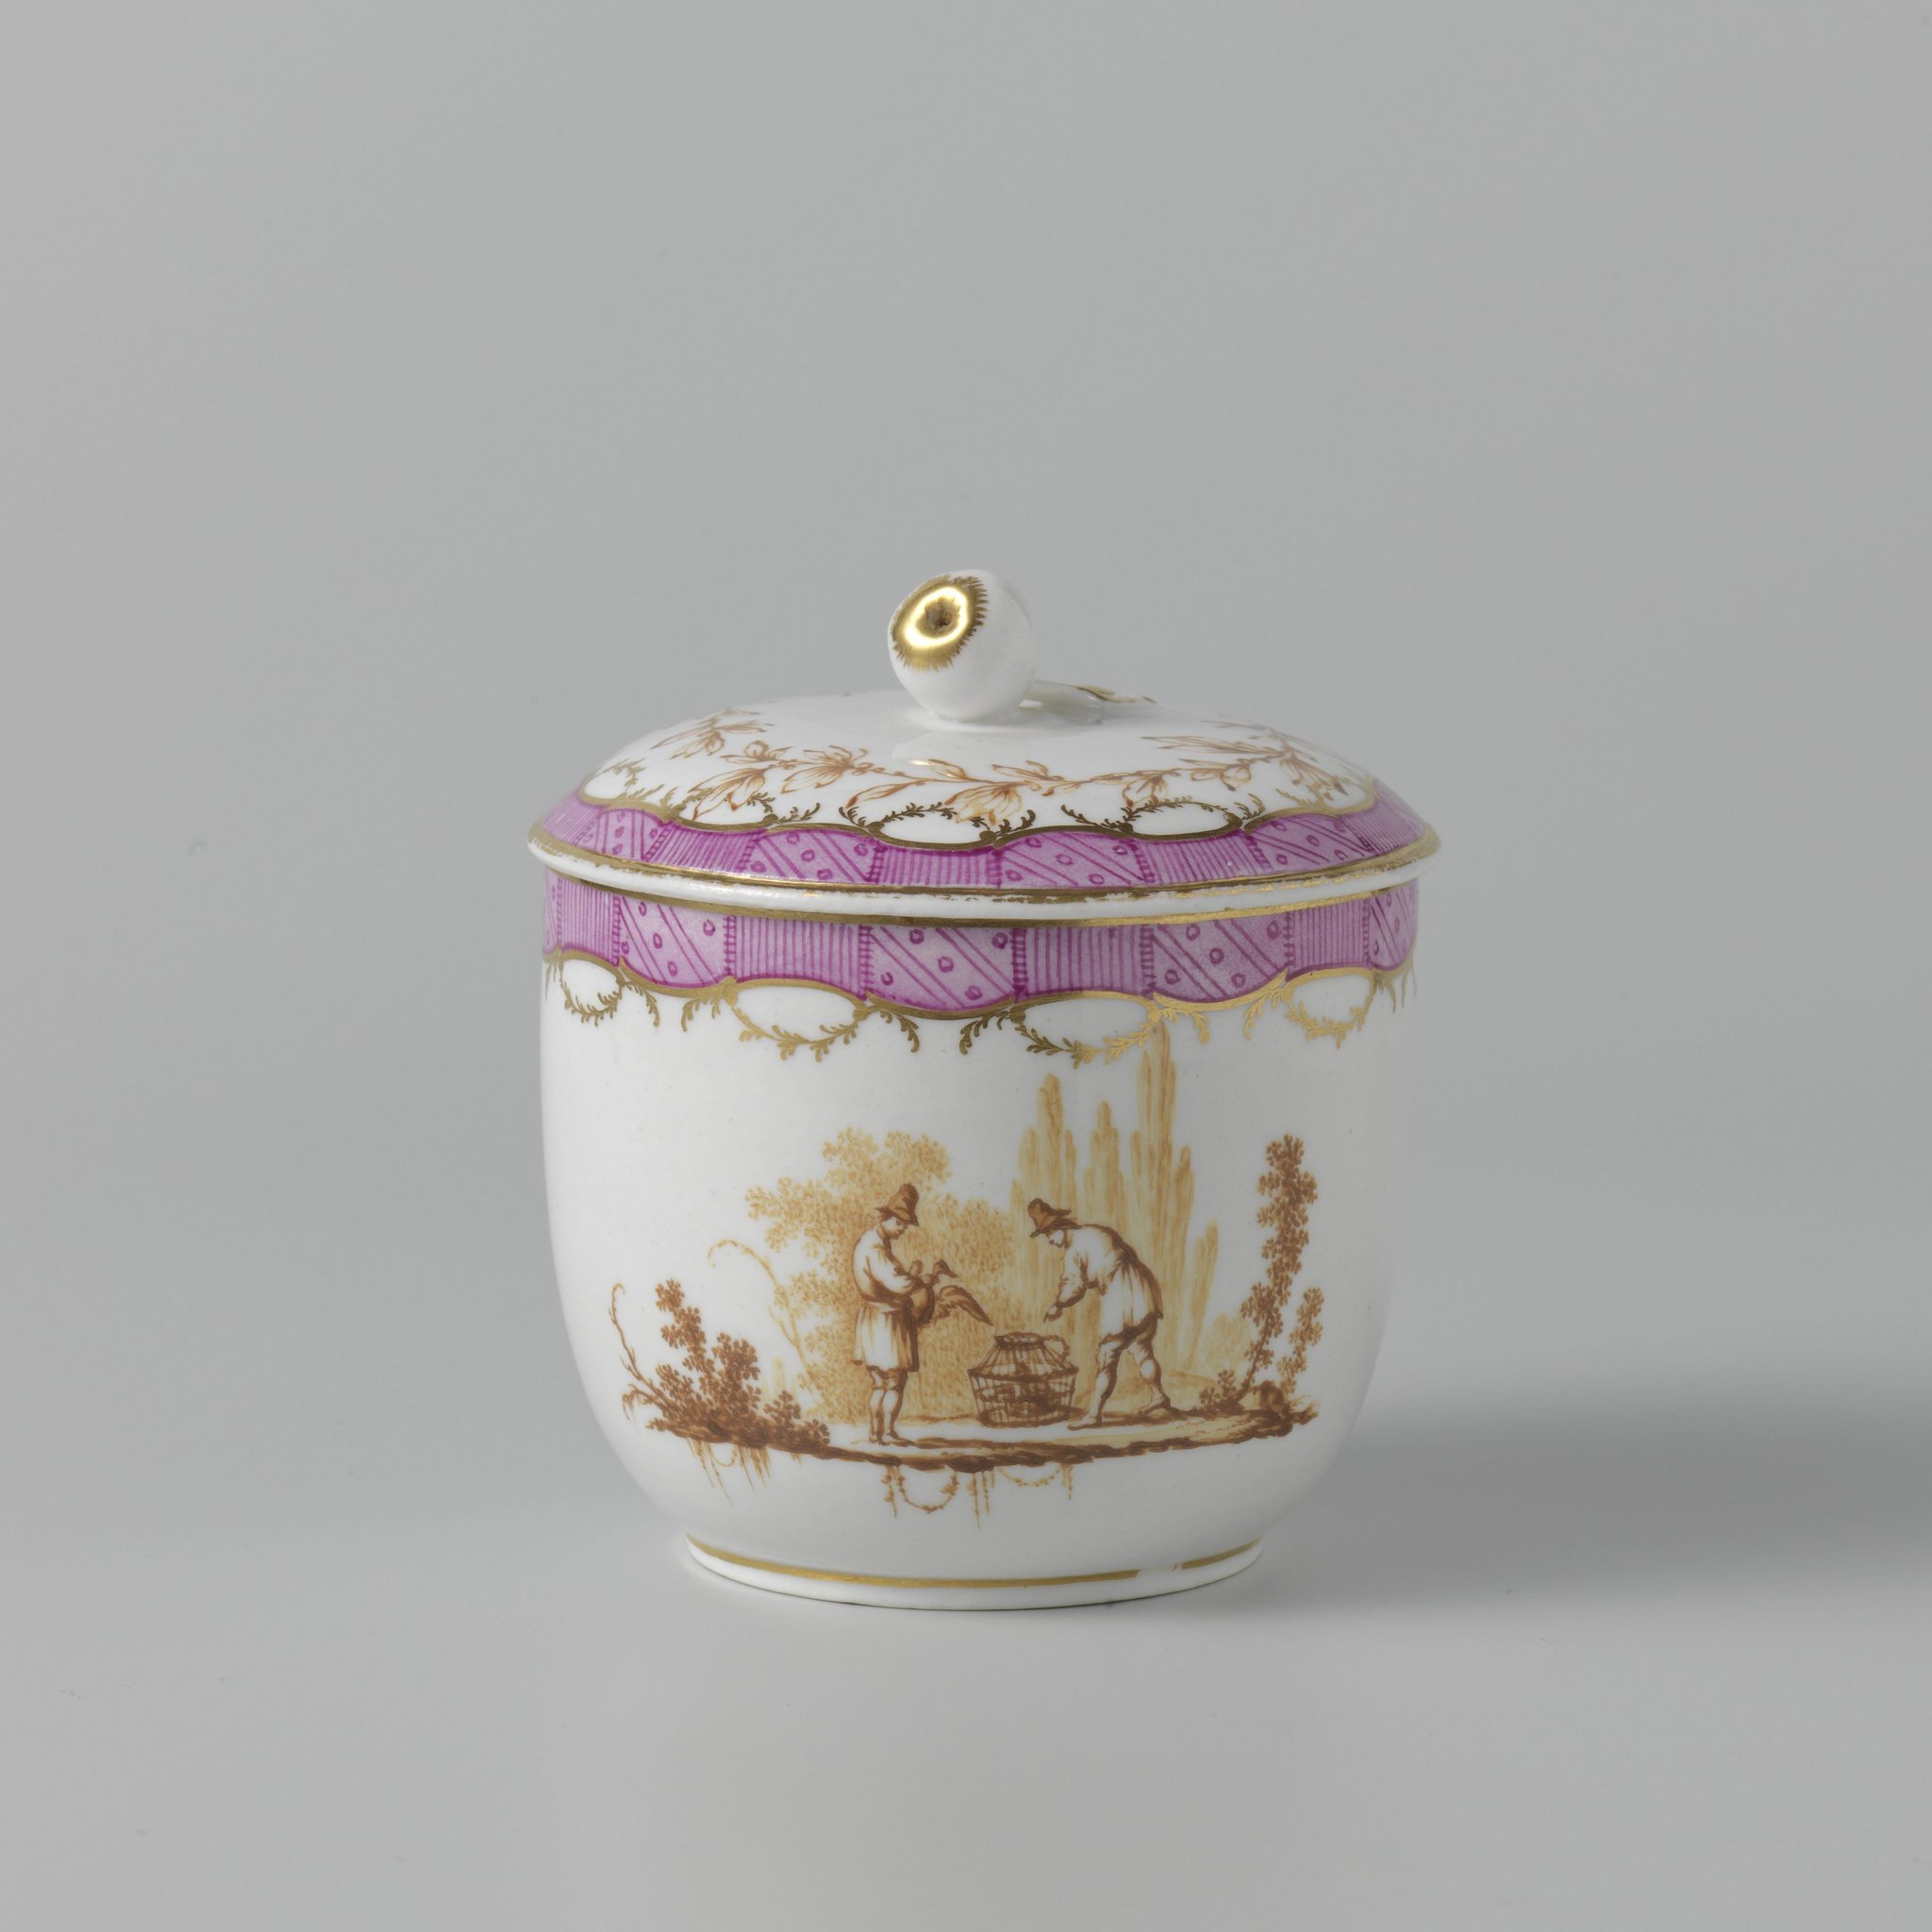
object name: sugar box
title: Tea service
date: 1774-1778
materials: porcelain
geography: loosdrecht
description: Tea services represented a significant part of the production of the Loosdrecht porcelain factory. On display here are a teapot, milk jug and sugar bowl along with other less familiar parts of a tea service, such as a slop bowl, which is used to rinse and warm the cups between two ‘courses’, and a drip catcher (pattipan), which catches the drips from the spout of the teapot.